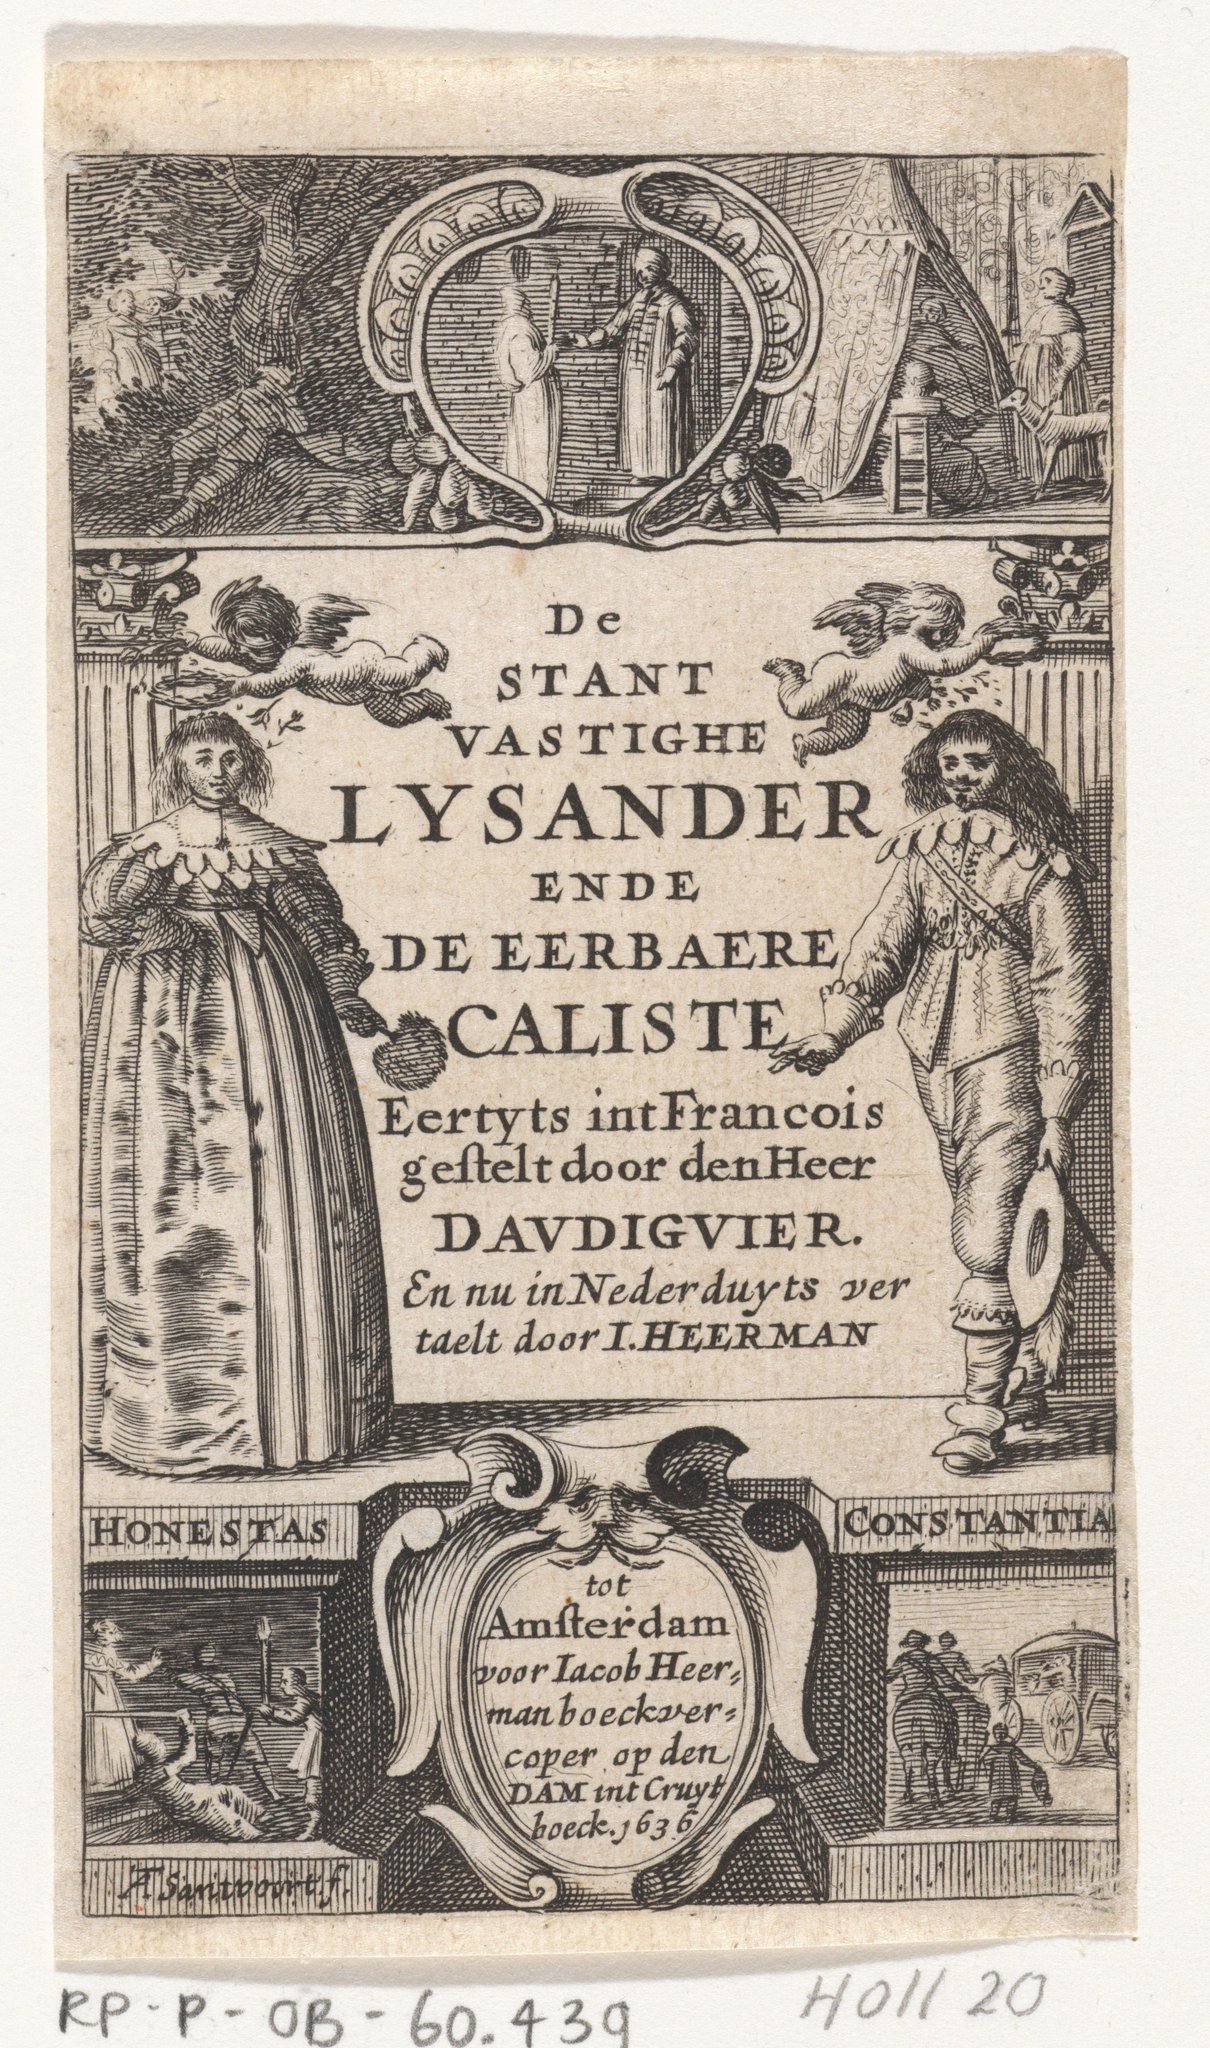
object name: titelblad, titelpagina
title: Scènes uit het leven van Lysander en Caliste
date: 1636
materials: paper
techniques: etching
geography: amsterdam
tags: adult woman, adult man, title-page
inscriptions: collector's mark: Lugt 2228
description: In het midden de titel en daaronder in een cartouche de naam van de uitgever. Links Caliste voor een zuil met een putto die bloemen over haar heen strooit. Onder haar voeten het Latijnse woord voor eer. Rechts Lysander voor een zuil. Boven hem is ook een putto te zien. Daaronder het Latijnse woord voor standvastigheid. Boven en onder in totaal vijf voorstellingen uit het leven van Caliste en Lysander.